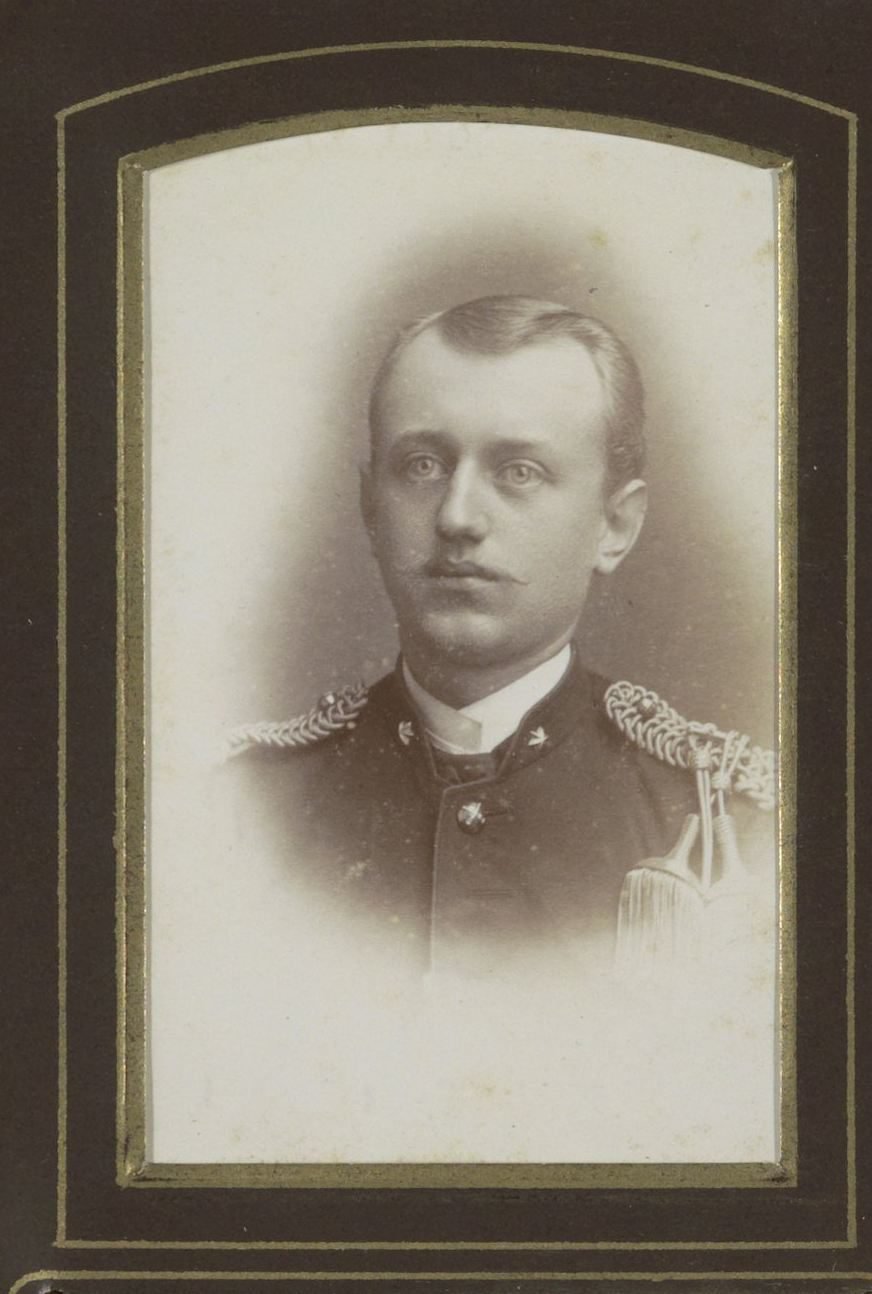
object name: photograph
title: Portret van een man in een militair uniform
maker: franz reissig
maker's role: fotograaf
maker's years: 1852-1936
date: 1883-1895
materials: cardboard, paper, photographic support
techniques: albumen print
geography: breda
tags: adult man, (military) uniforms, historical persons not known by name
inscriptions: address: ‘129B Ginnekenstraat 129B’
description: Onderdeel van Fotoalbum van de families Matthes, Doorman en Van Thiel.